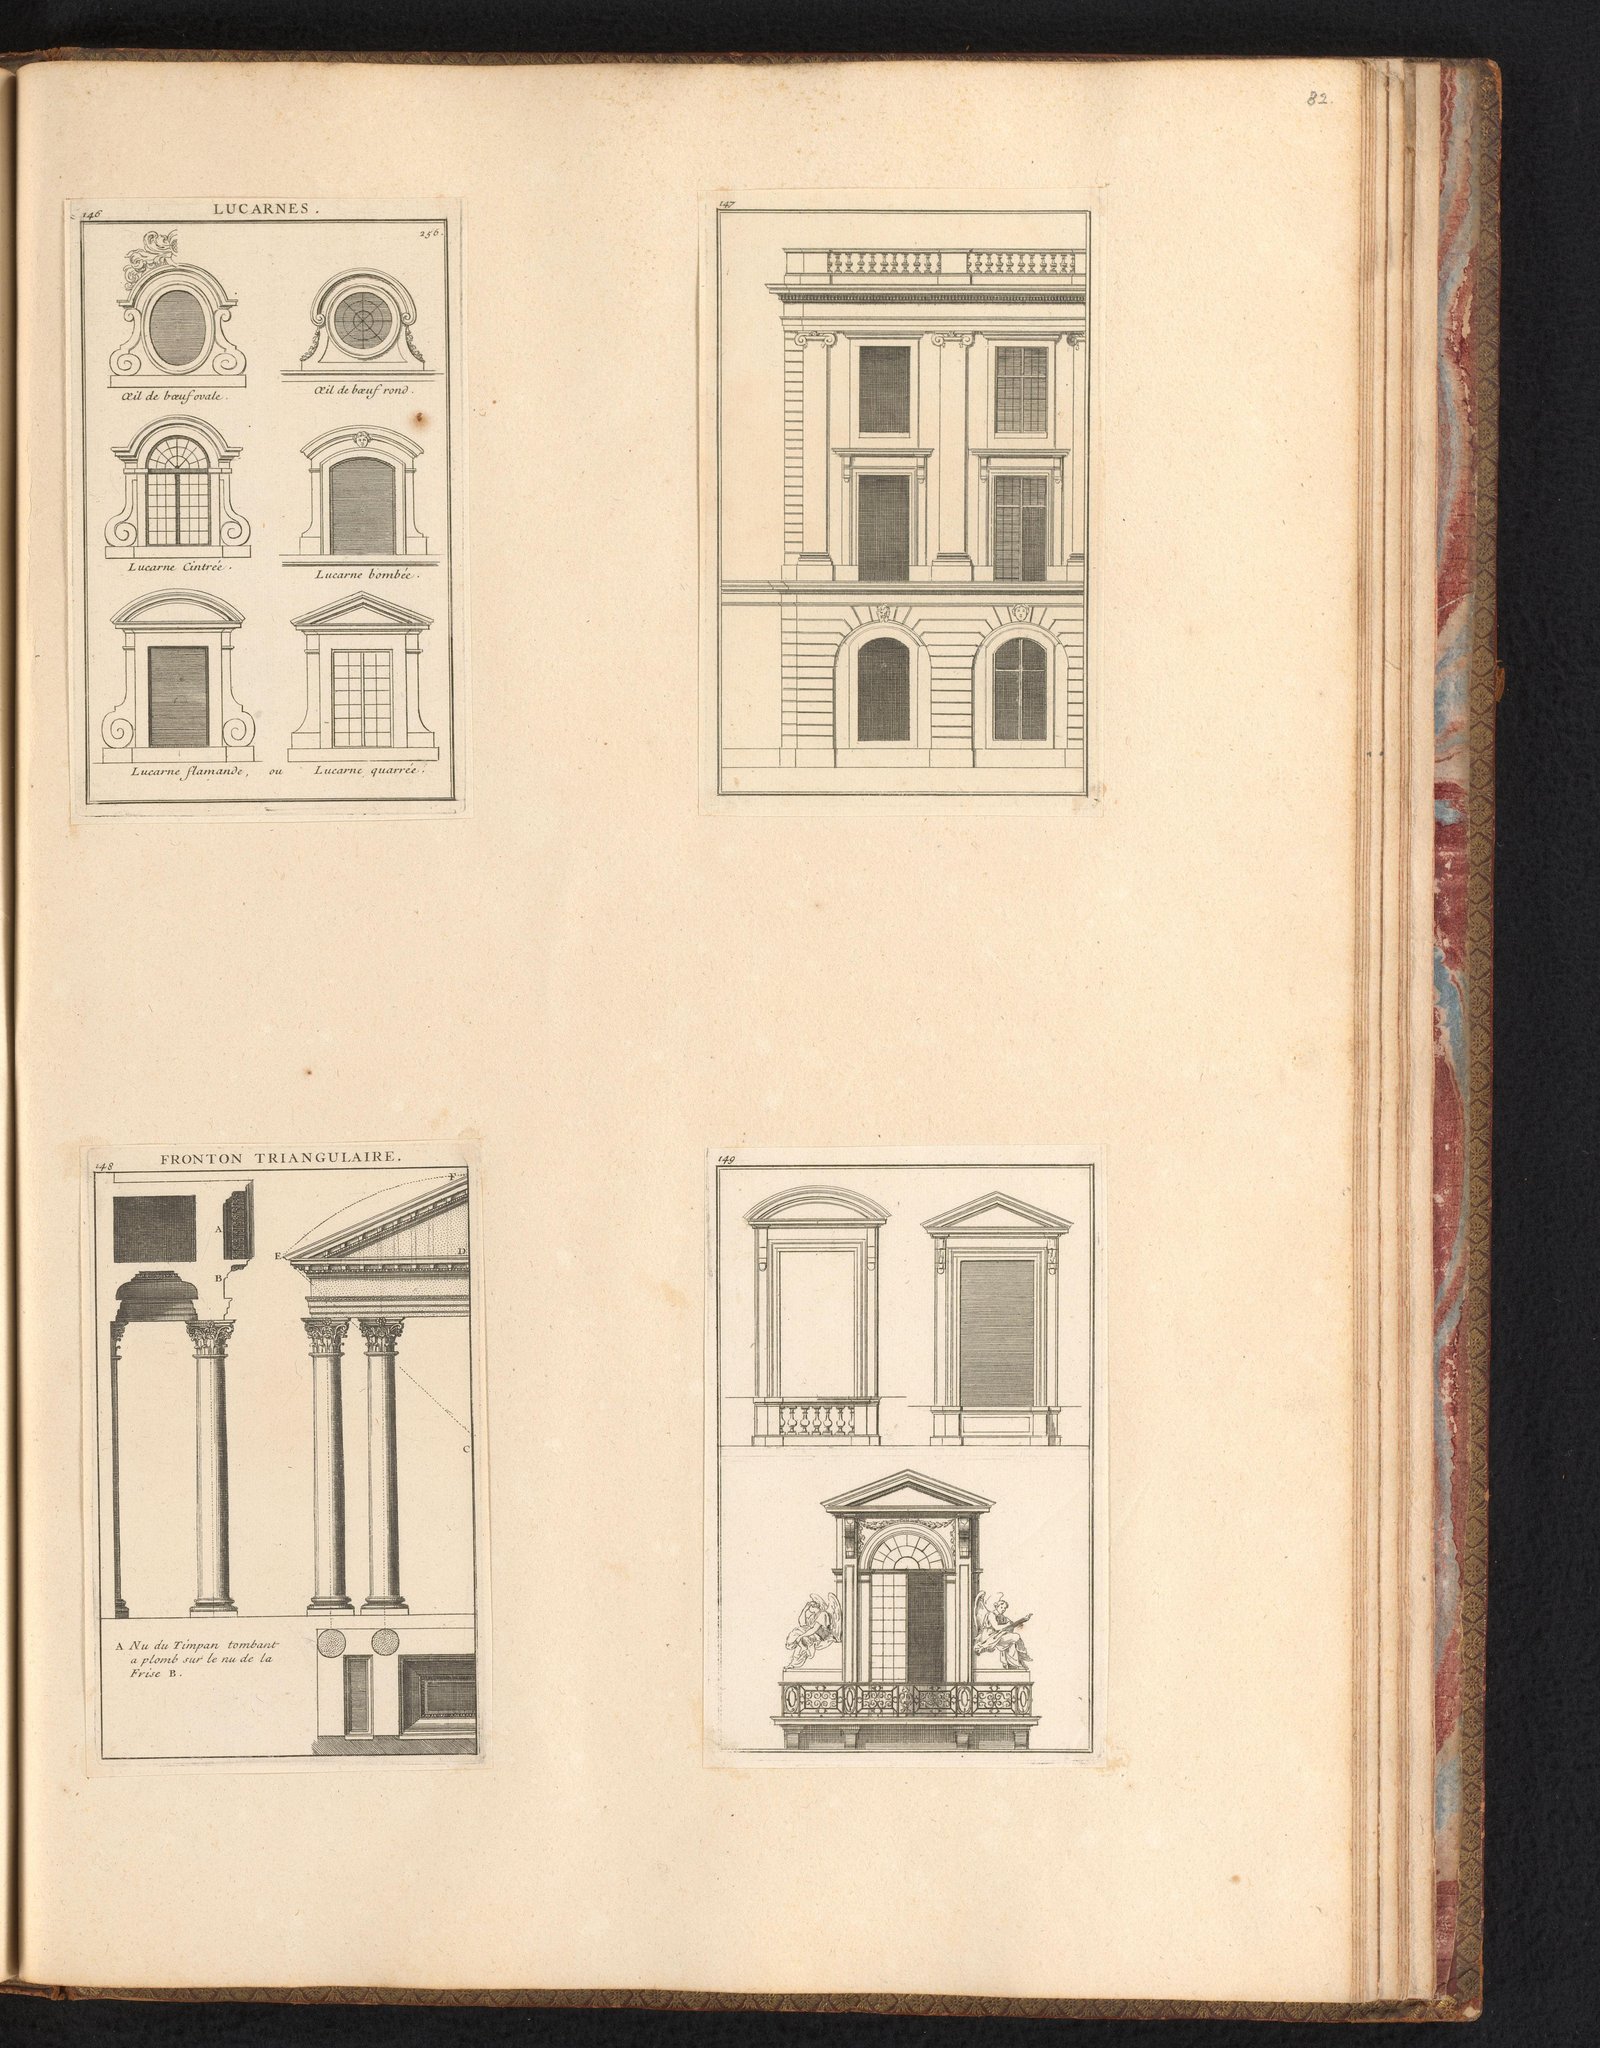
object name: print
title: Klassieke architecturale elementen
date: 1714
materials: paper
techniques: etching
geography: paris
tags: window, other architectural details (with name), architectural detail, door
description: Prenten uit: Leclerc, Sébastien (I). Traité d'architecture. Parijs: Pierre François Giffart, 1714.